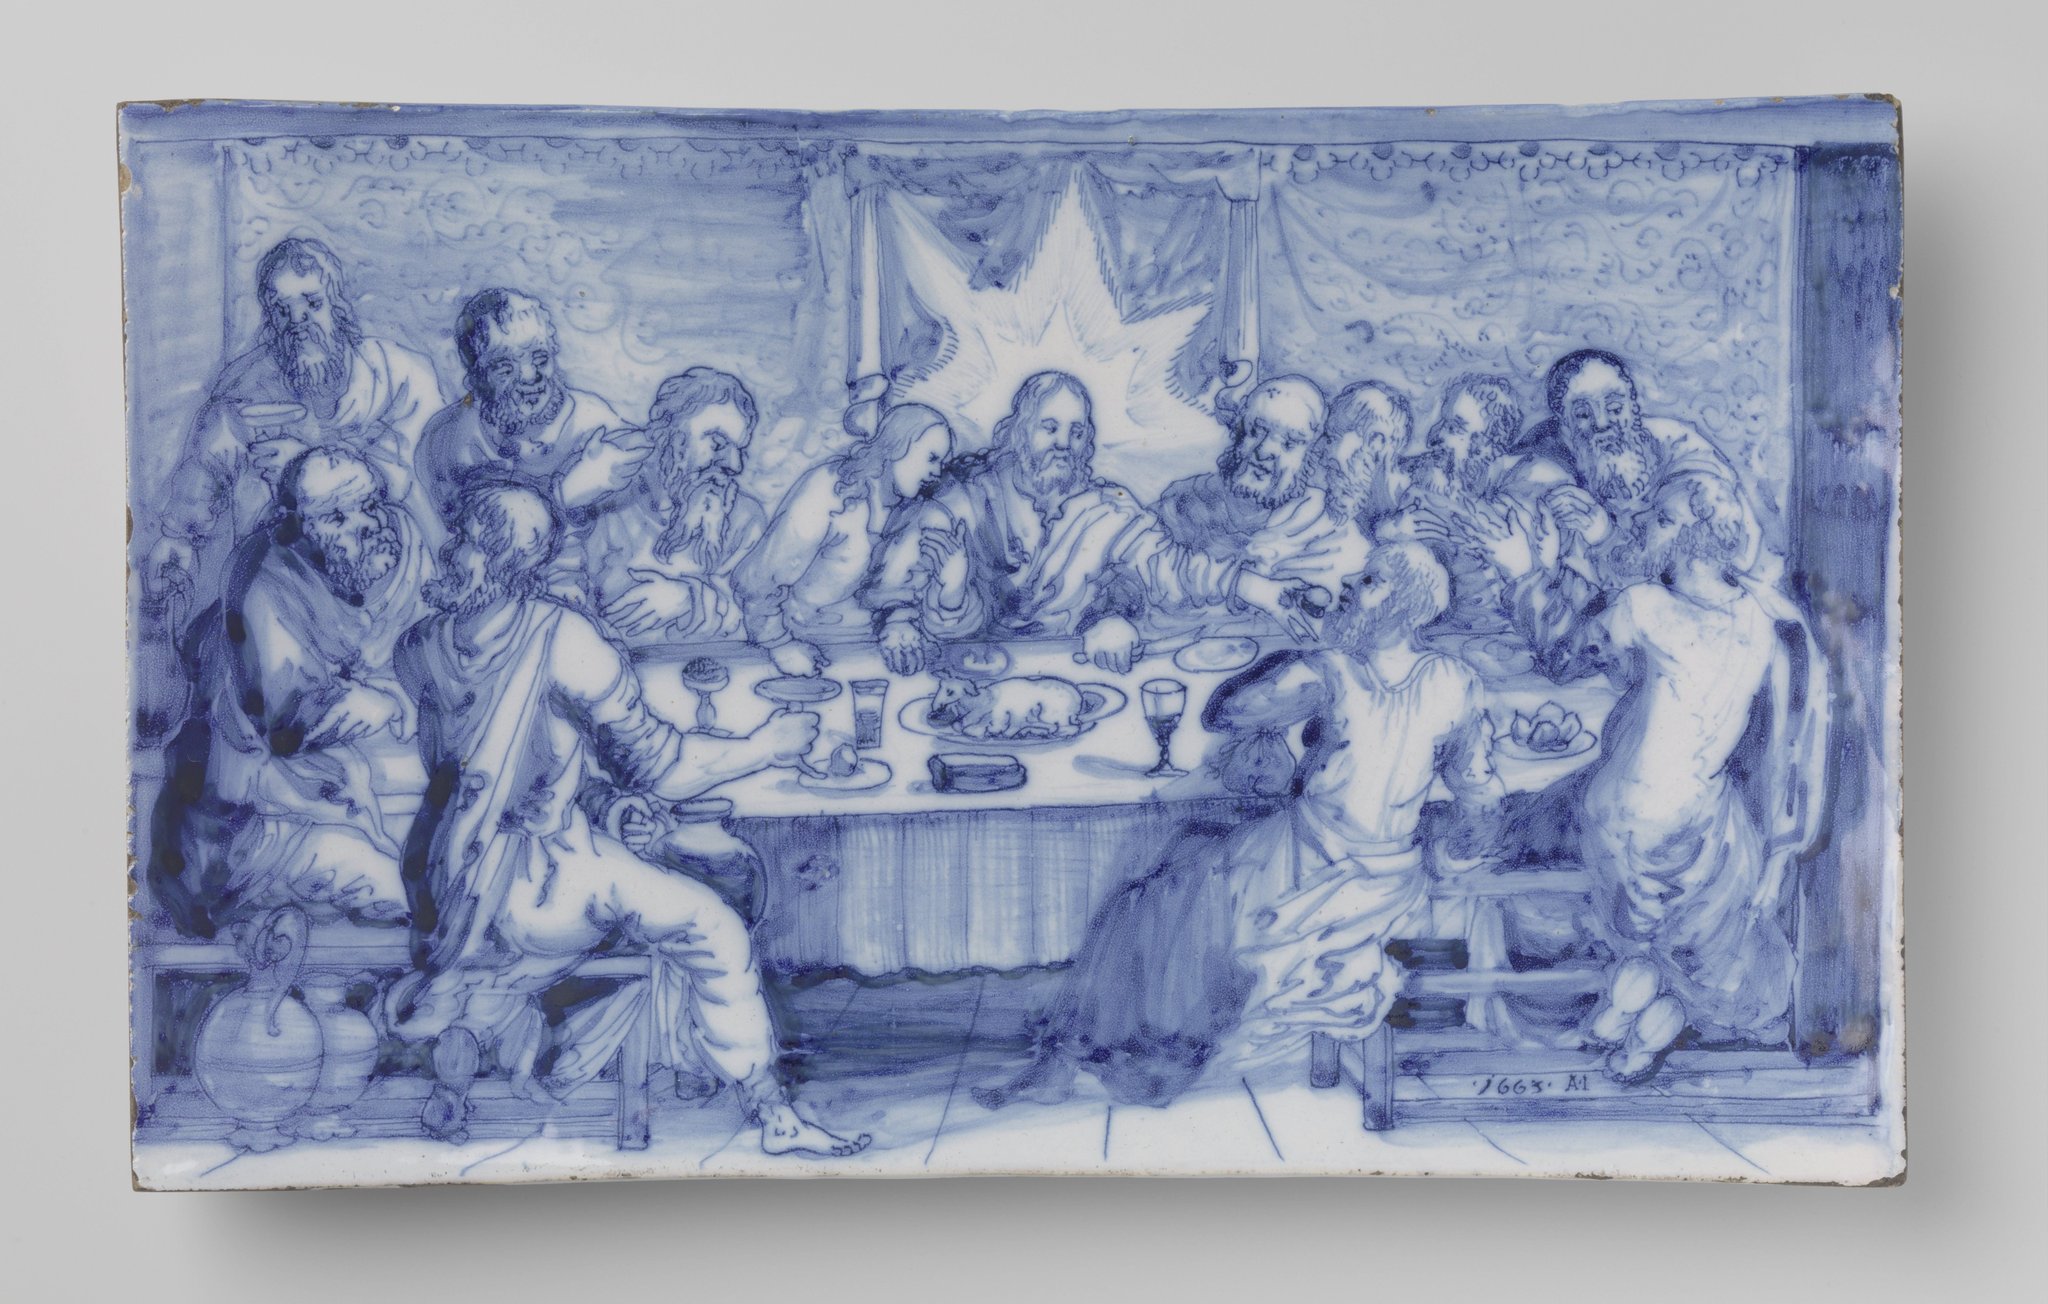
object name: plate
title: Plaque with The Last Supper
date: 1663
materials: earthenware, glaze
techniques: painted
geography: delft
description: Plaat van Delfts aardewerk met een voorstelling van het Laatste Avondmaal.